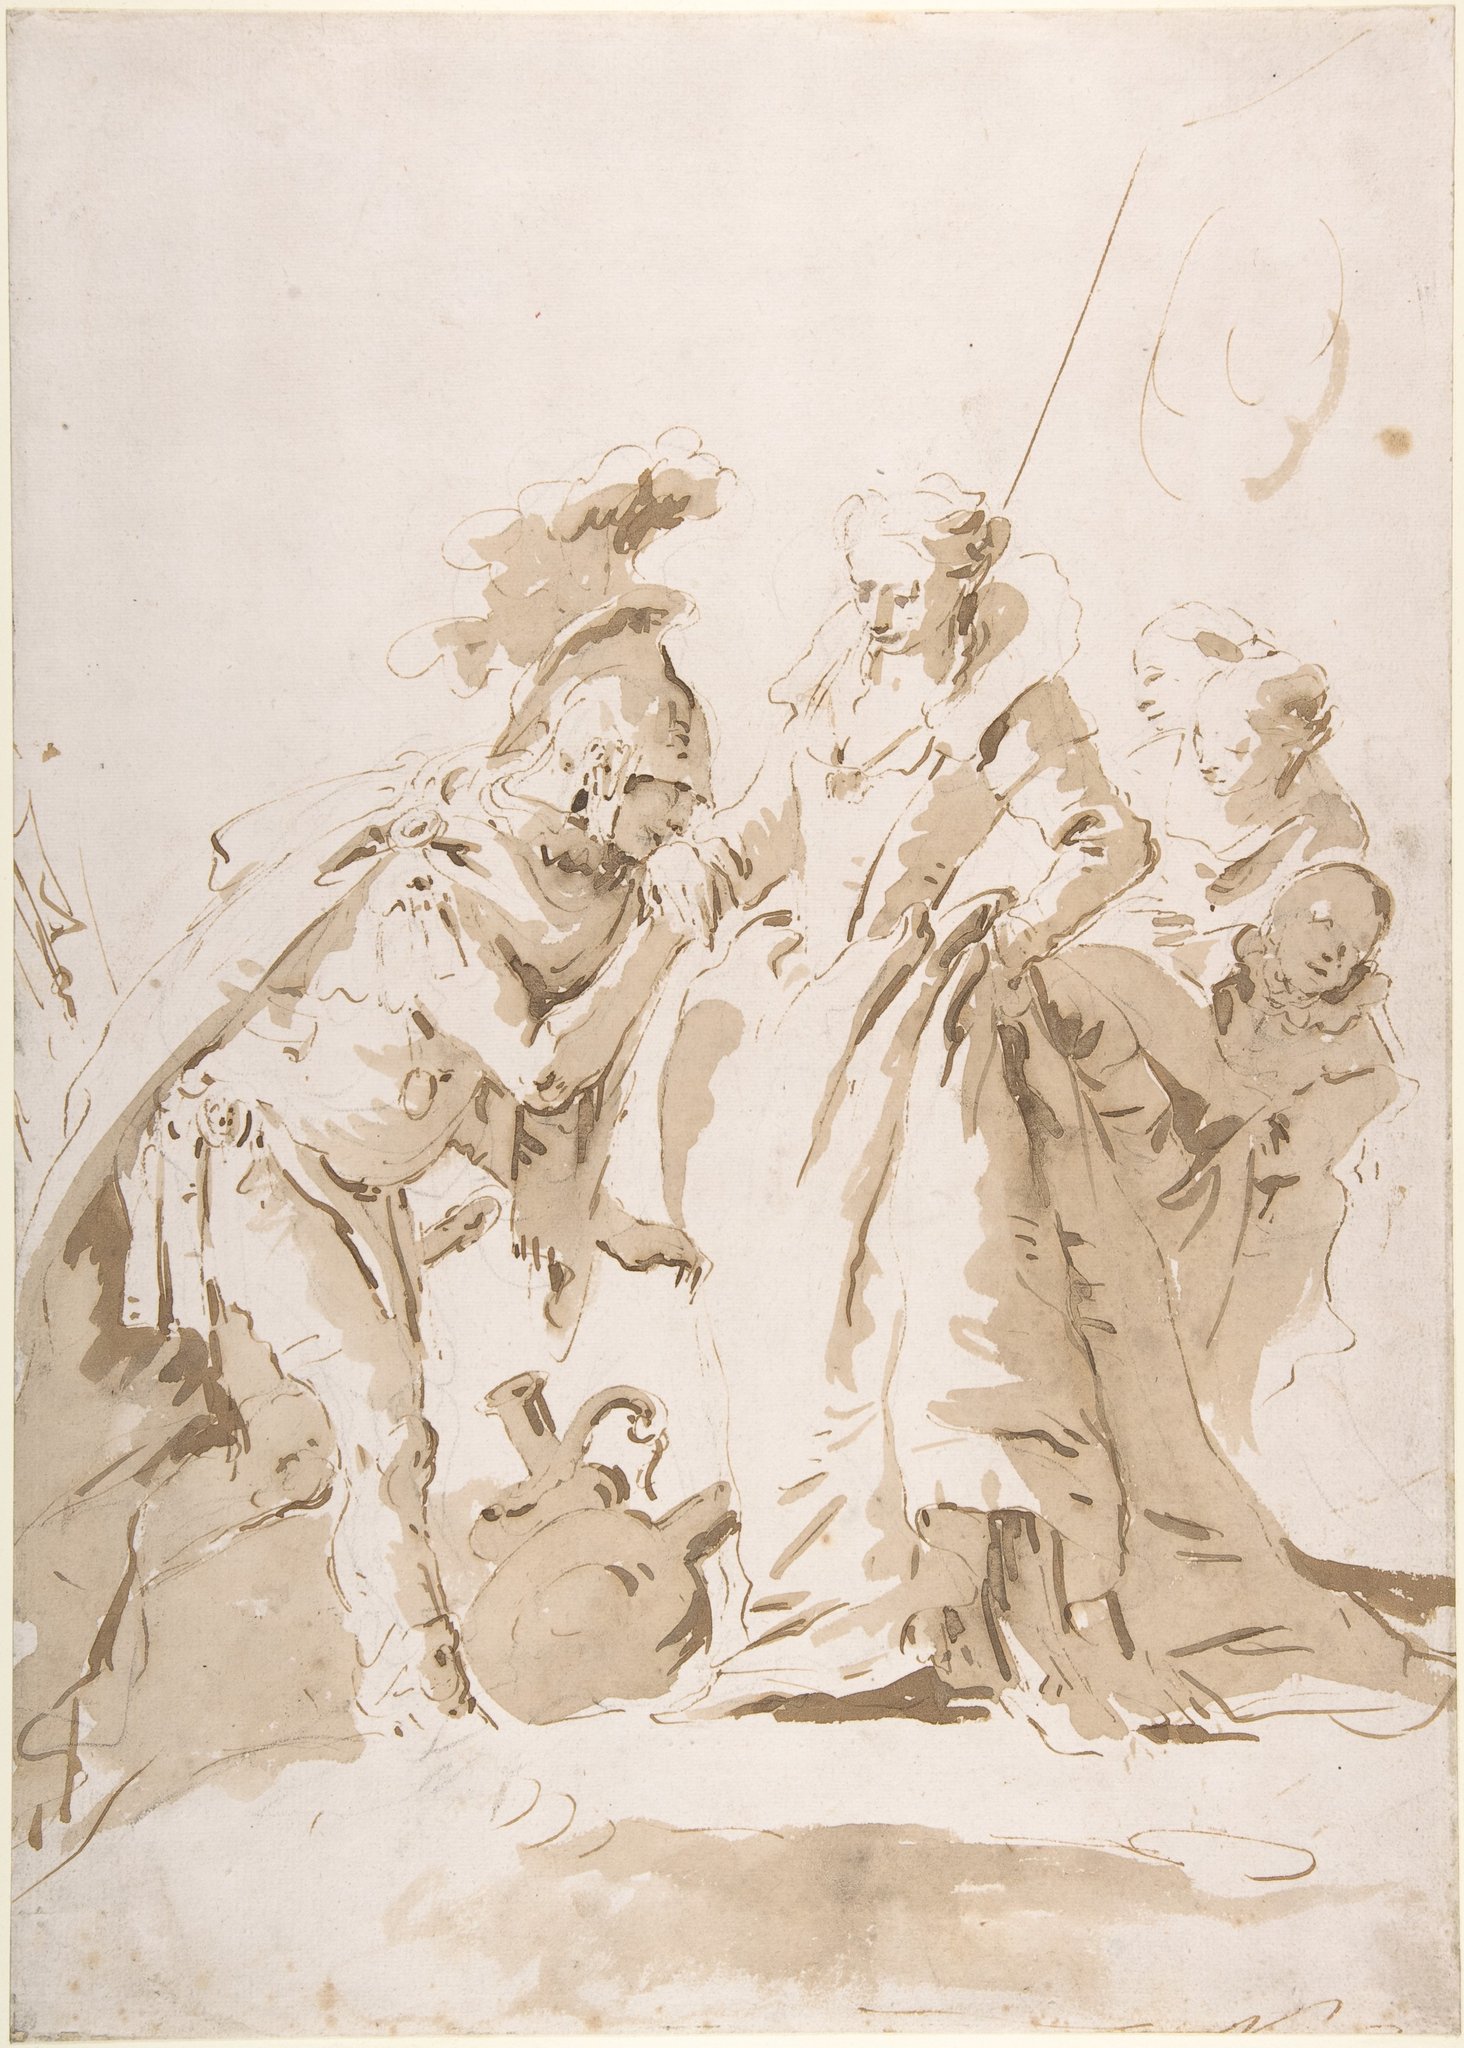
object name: drawing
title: The Meeting of Anthony and Cleopatra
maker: giovanni battista tiepolo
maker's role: artist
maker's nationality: italian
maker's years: 1696-1770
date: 1696-1770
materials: chalk, ink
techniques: brush, pen, wash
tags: cleopatra,men